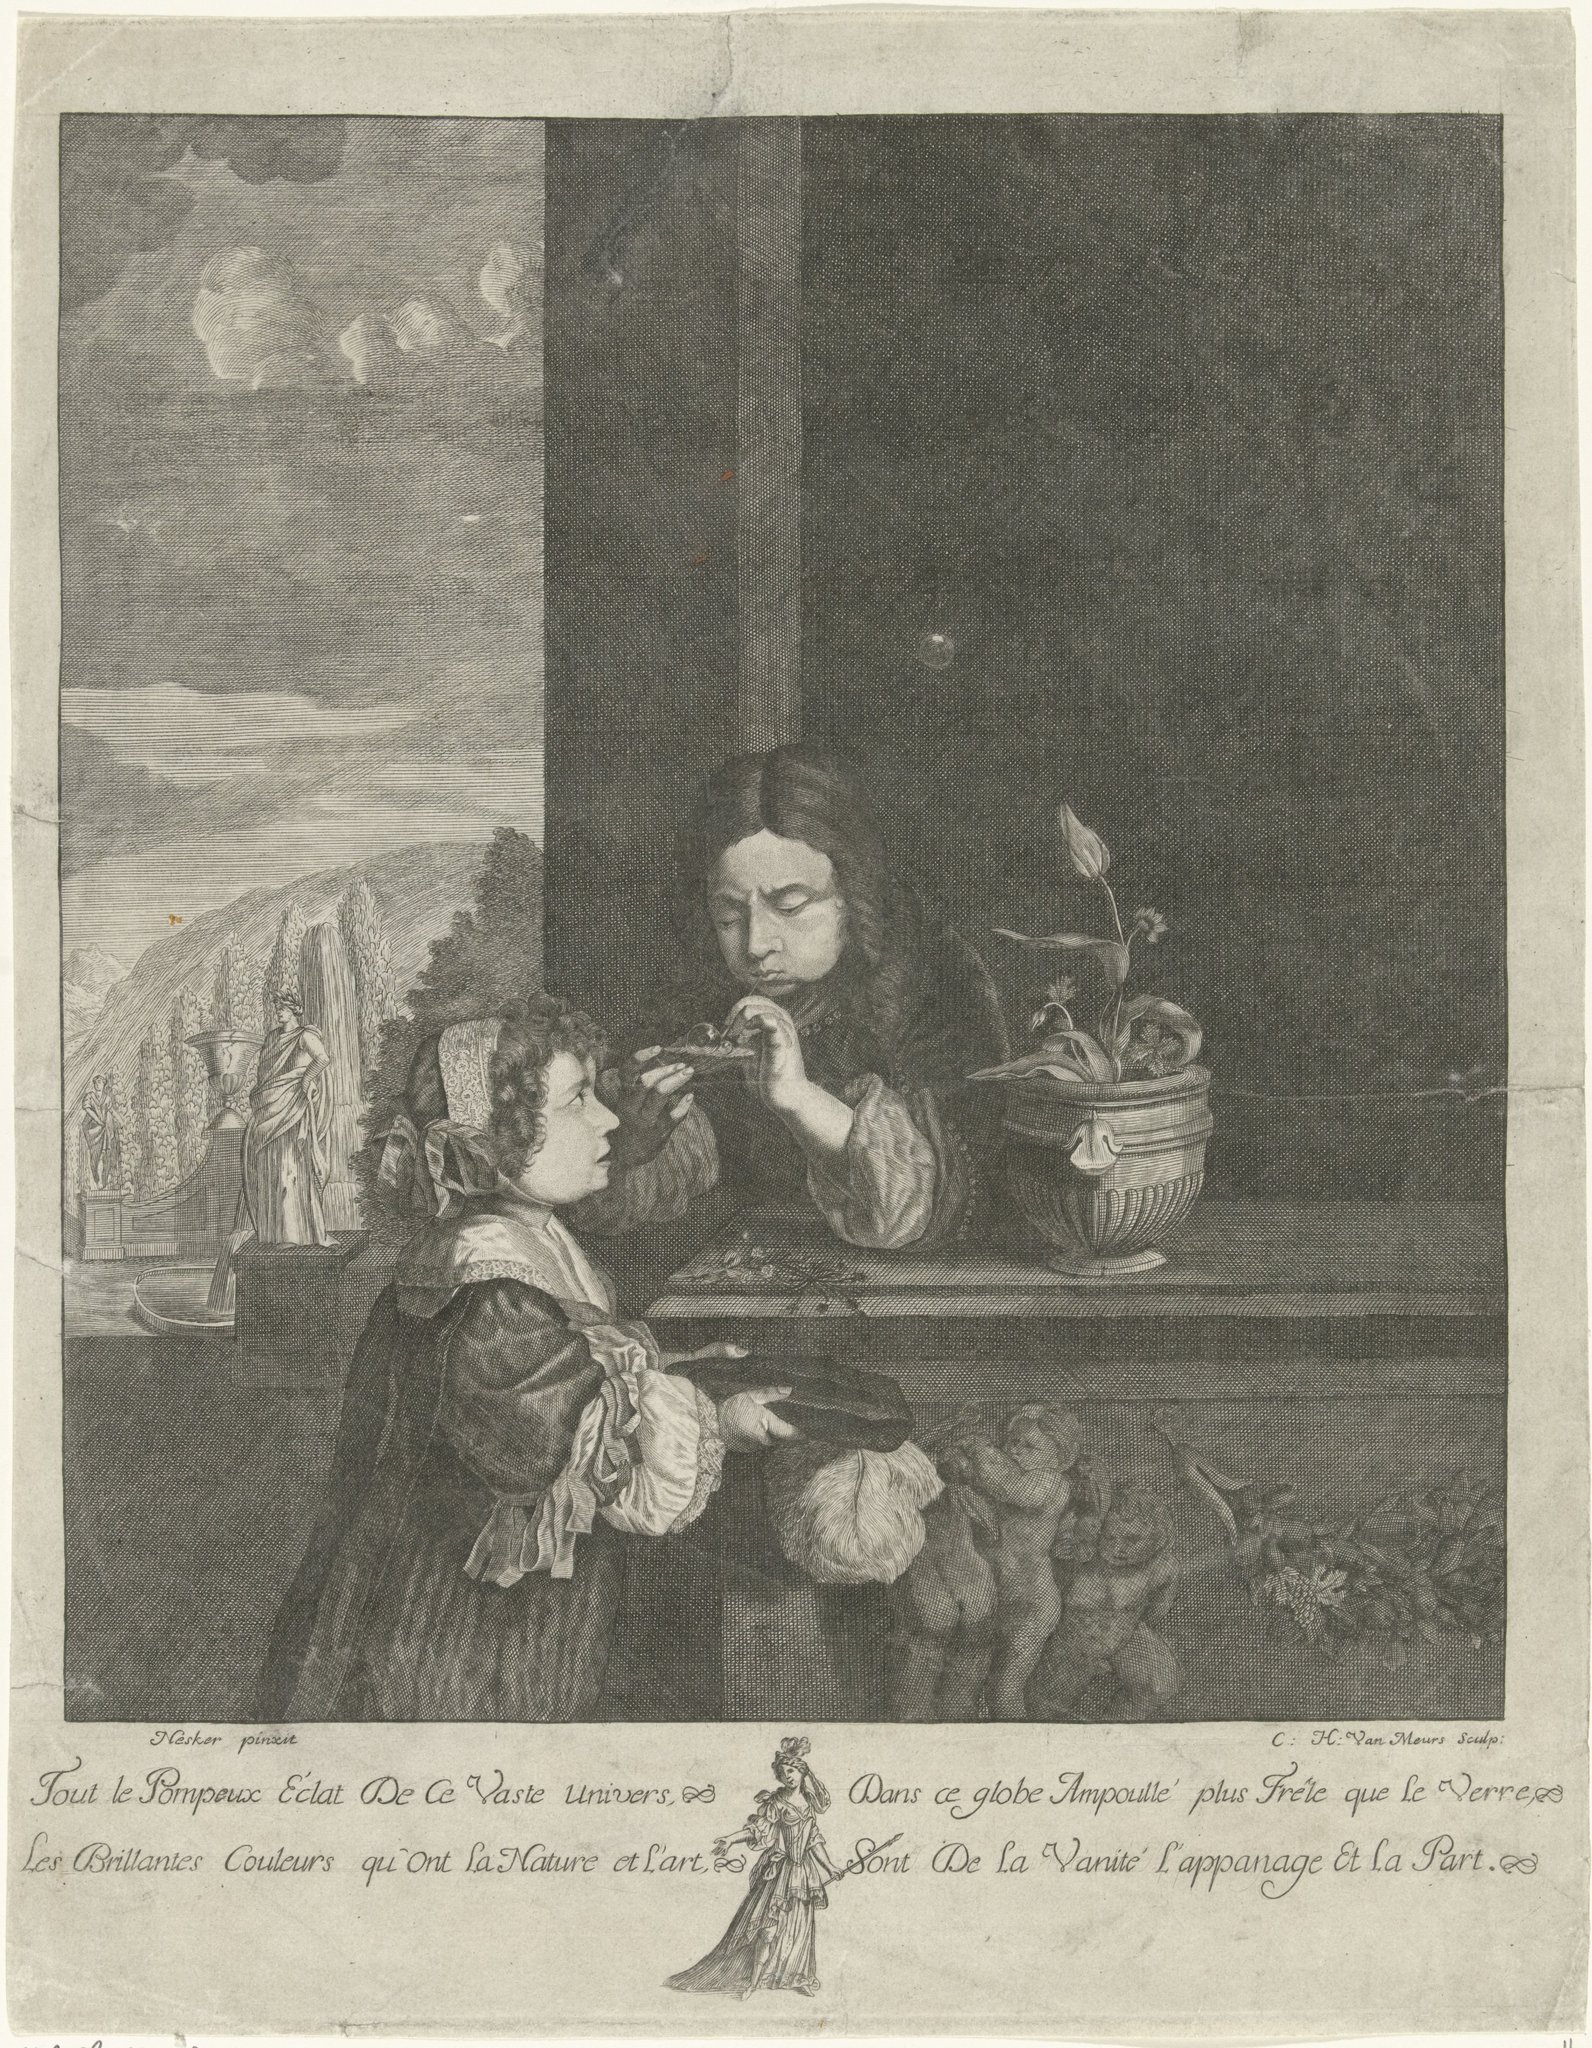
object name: print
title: A boy and a girl blowing bubbles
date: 1720-1730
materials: paper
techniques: engraving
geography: northern netherlands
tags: bubble-blowing (children's games and plays), french or architectonic garden; formal garden, child (at home) - aa - girl, looking upwards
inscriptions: collector's mark: Lugt 2228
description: Een jongen, leunend op een balustrade, blaast bellen. Een meisje kijkt toe, terwijl zij zijn hoed vasthoudt. Op de achtergrond een tuin met standbeelden. Onderaan in de marge een tweeregelig vers in het Frans.